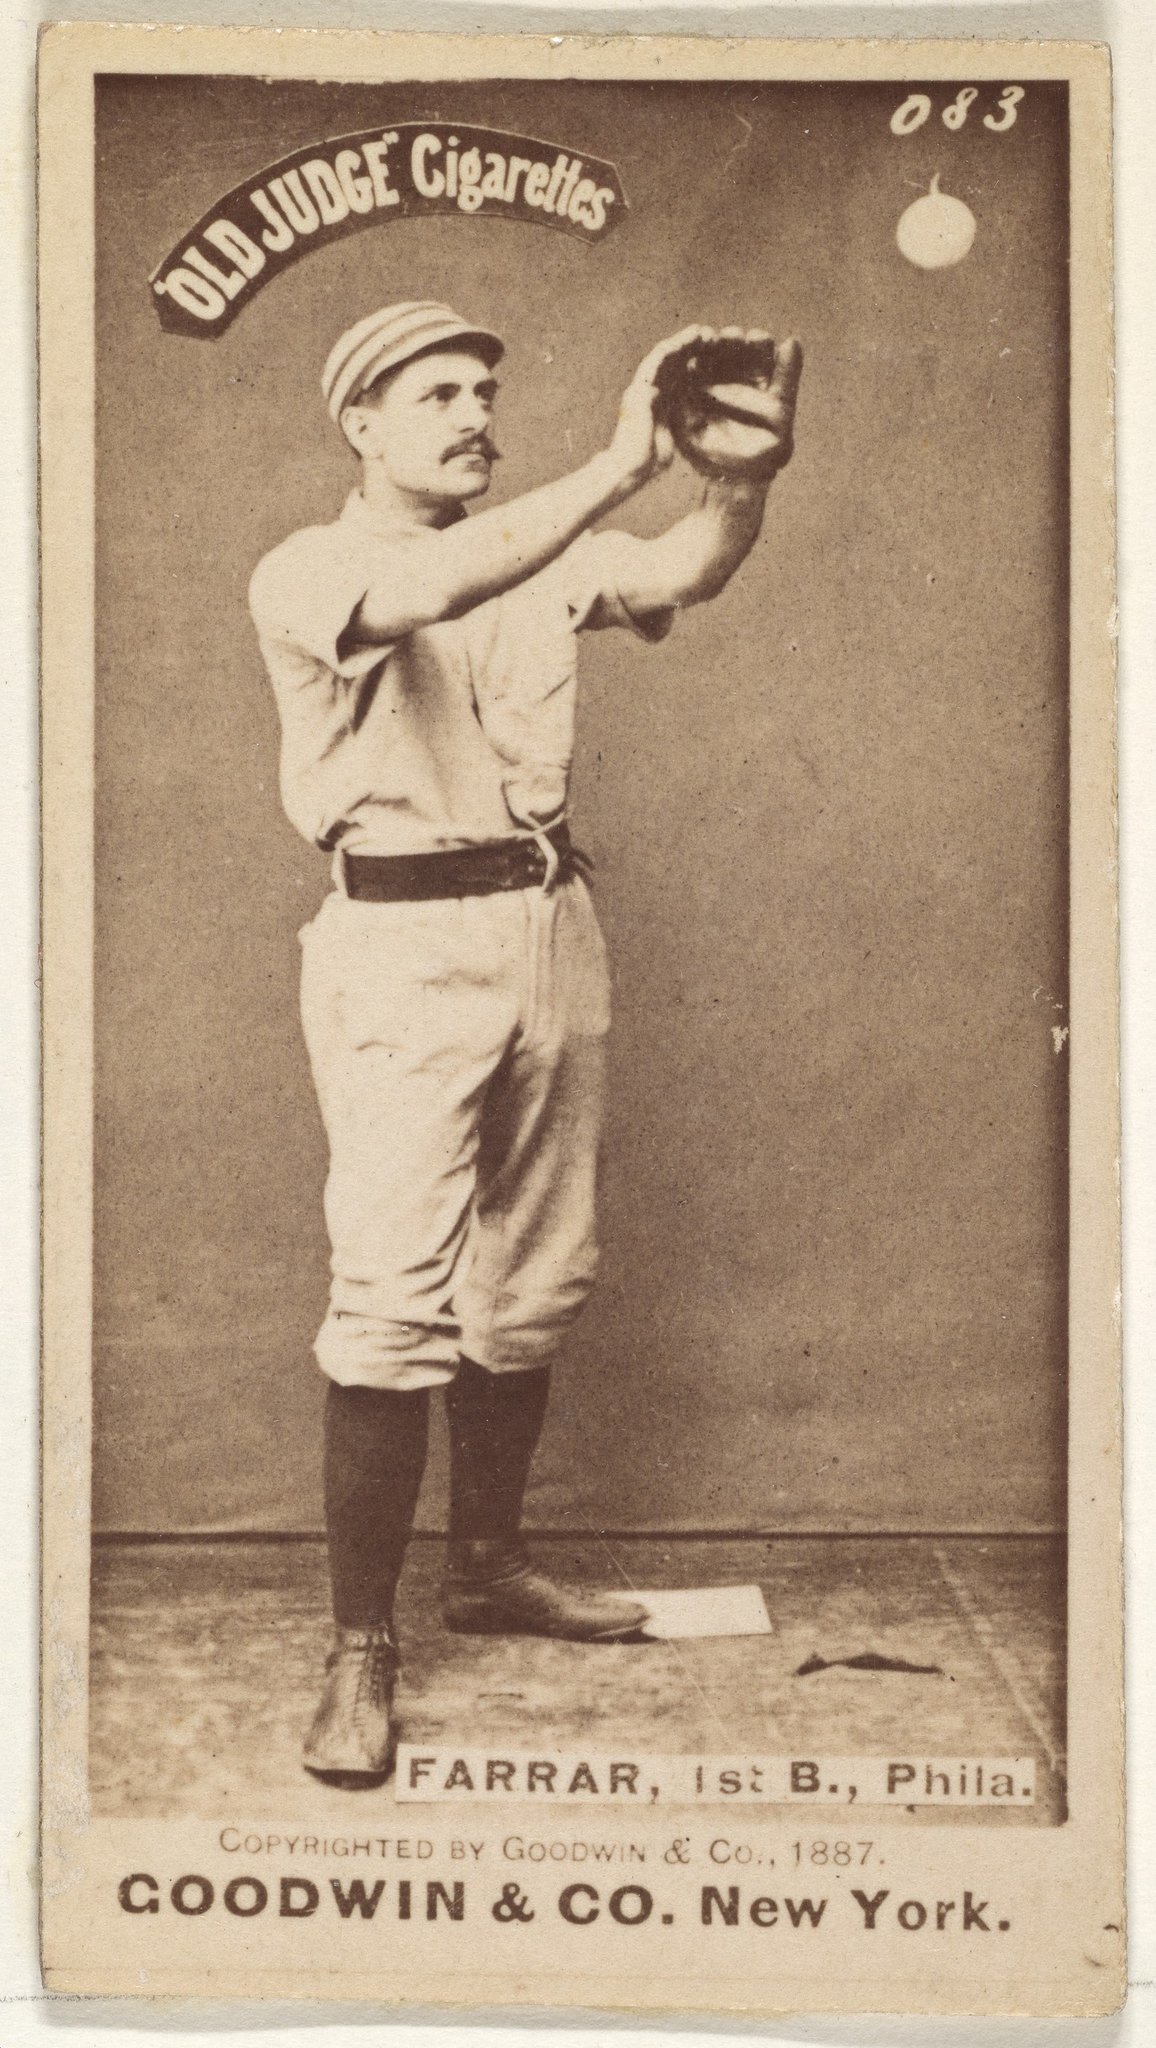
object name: baseball card, photograph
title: Sidney Douglas Farrar, 1st Base, Philadelphia, from the Old Judge series (N172) for Old Judge Cigarettes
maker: goodwin & company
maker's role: publisher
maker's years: 1850-1950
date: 1887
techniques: albumen silver print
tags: men,portraits,baseball,athletes